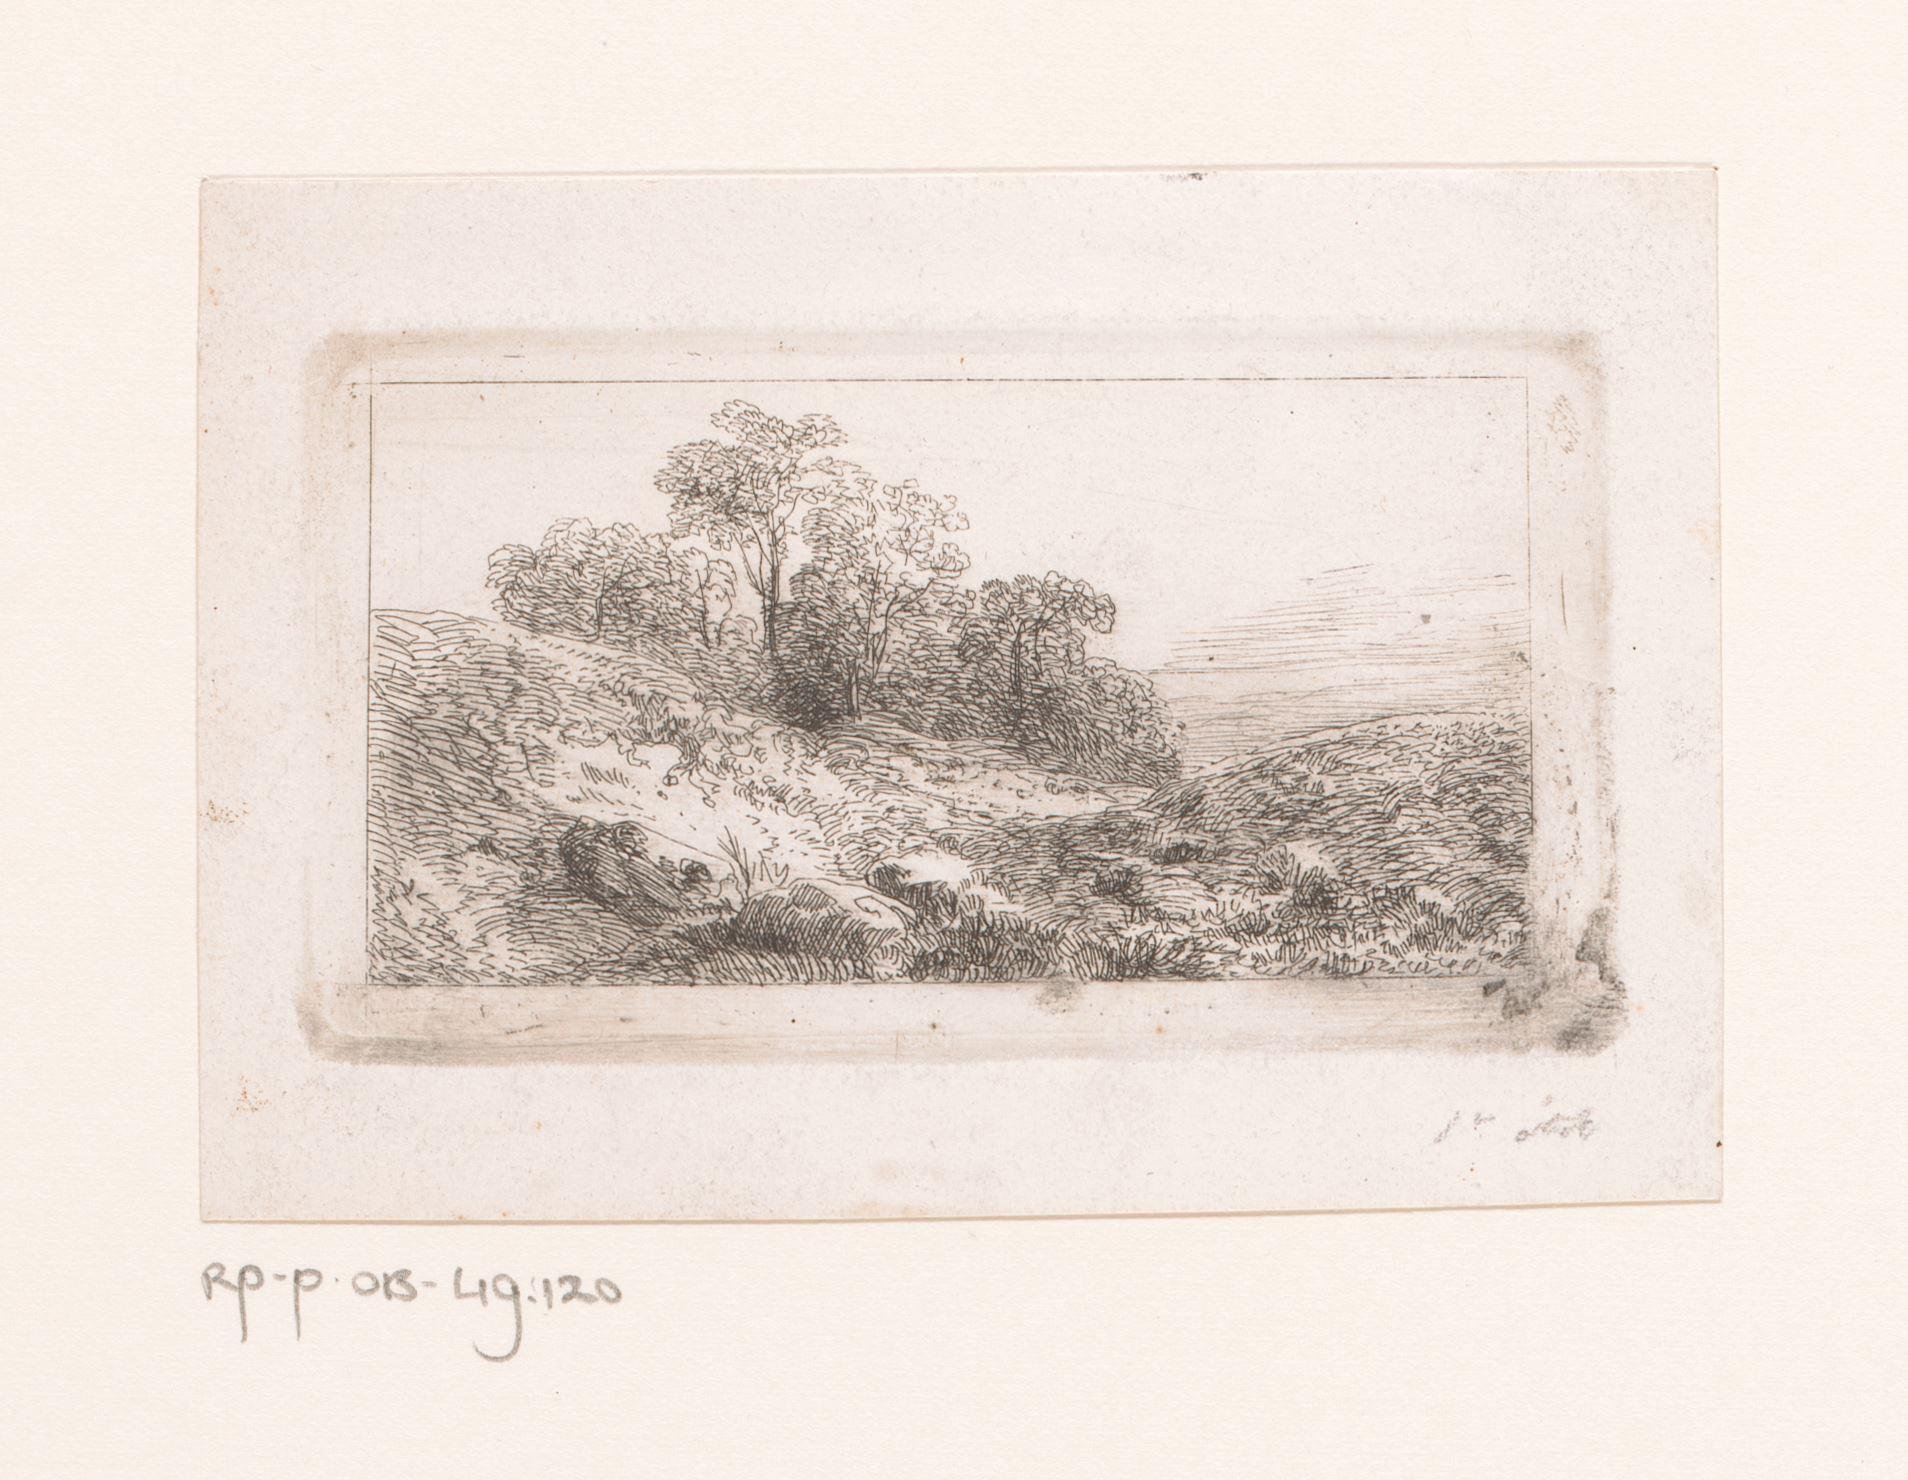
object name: print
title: Duinlandschap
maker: paulus lauters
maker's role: print maker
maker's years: 1806-1875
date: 1816-1875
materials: paper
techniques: etching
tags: dune coast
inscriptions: annotation: ‘1e état’, collector's mark: Lugt 2228